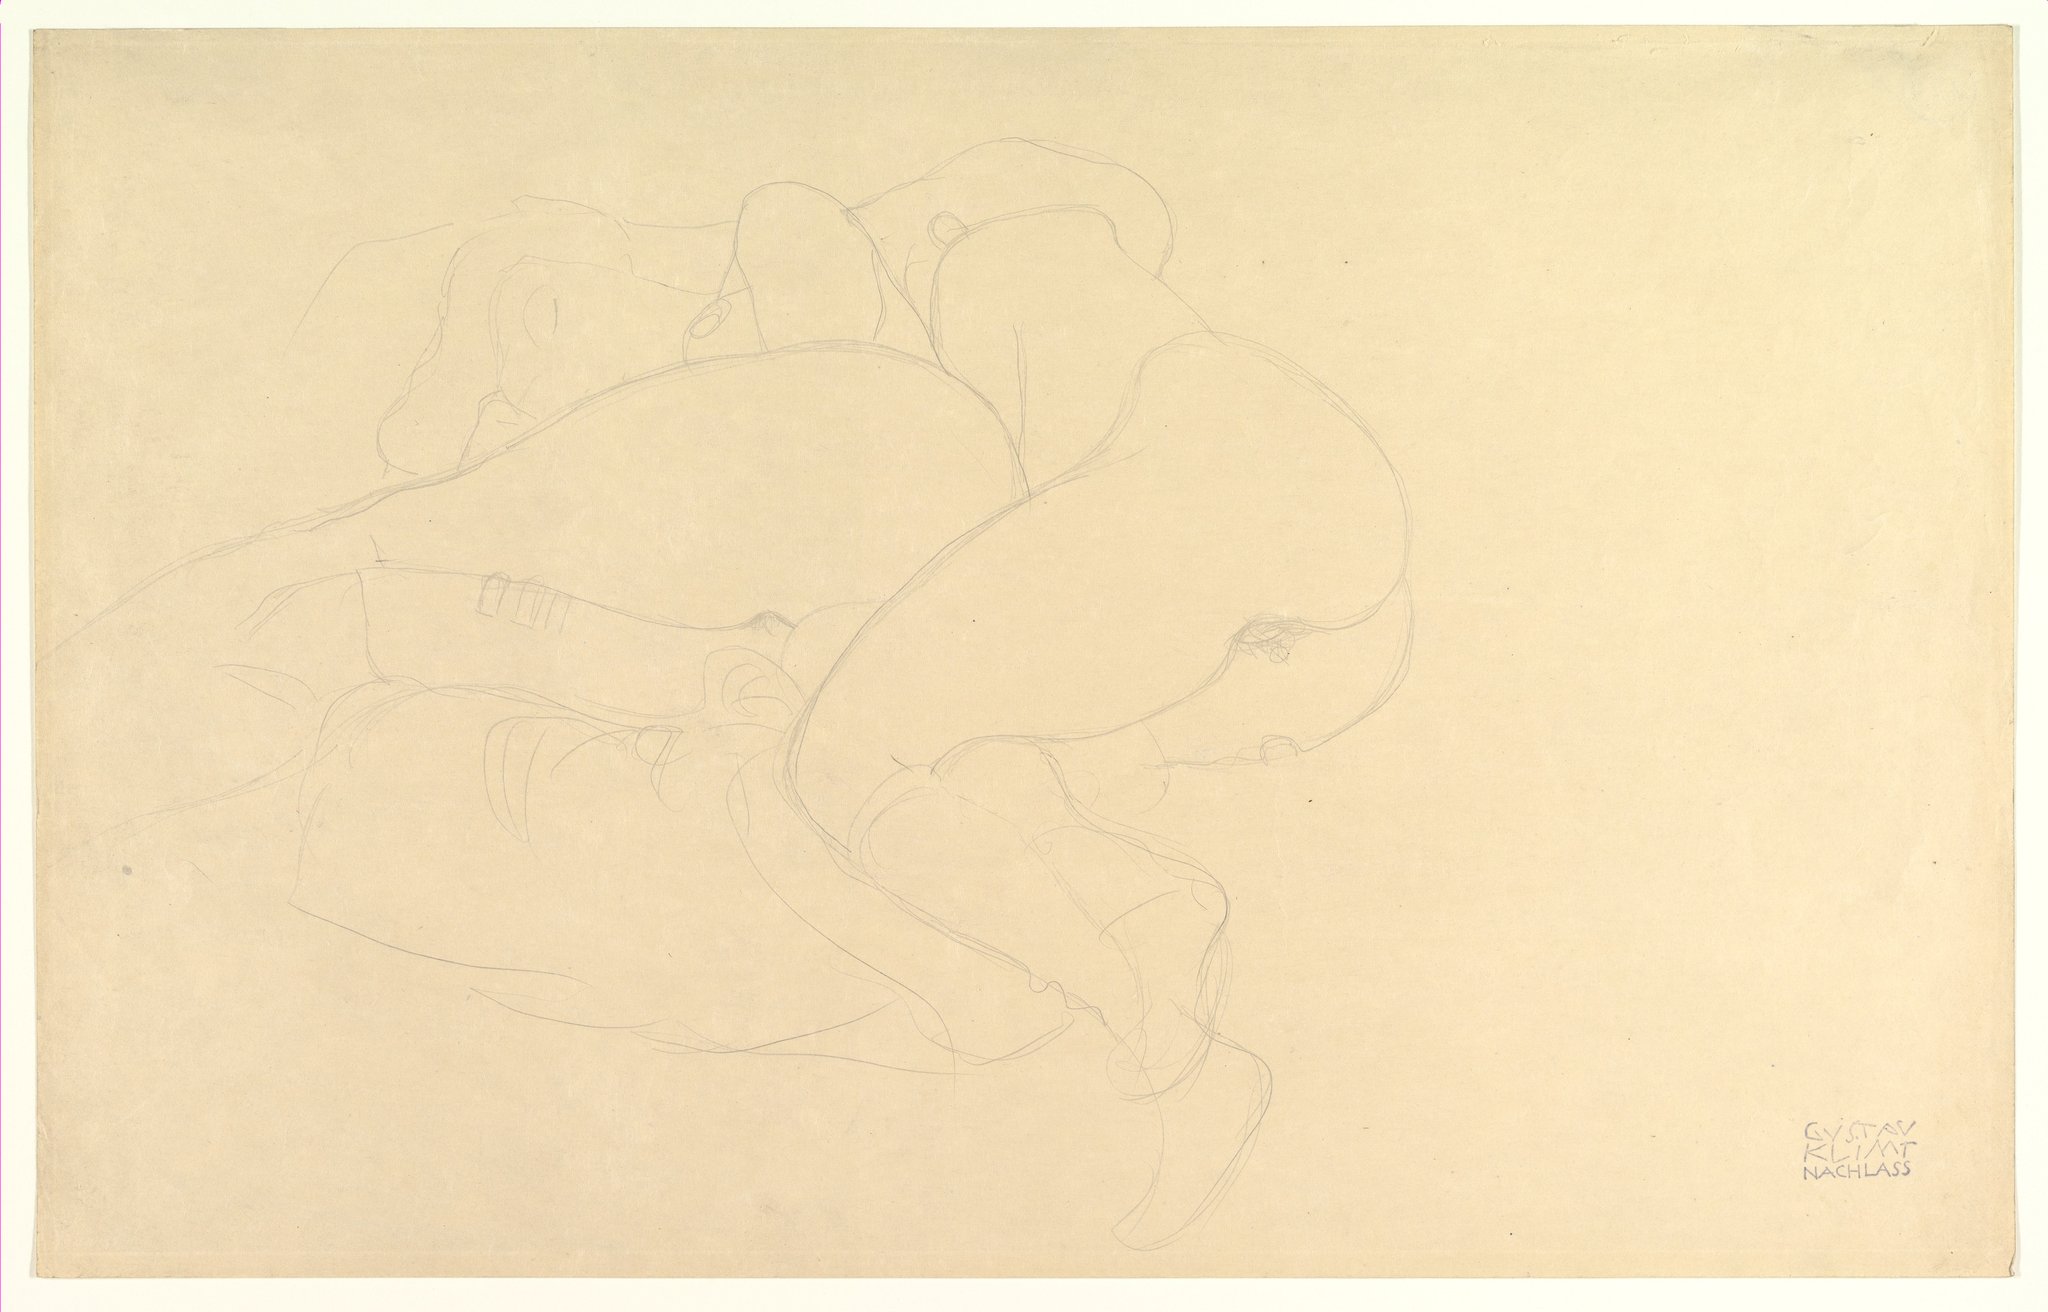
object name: drawing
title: Two Women Reclining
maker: gustav klimt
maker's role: artist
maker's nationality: austrian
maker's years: 1862-1918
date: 1905-1906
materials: graphite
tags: female nudes